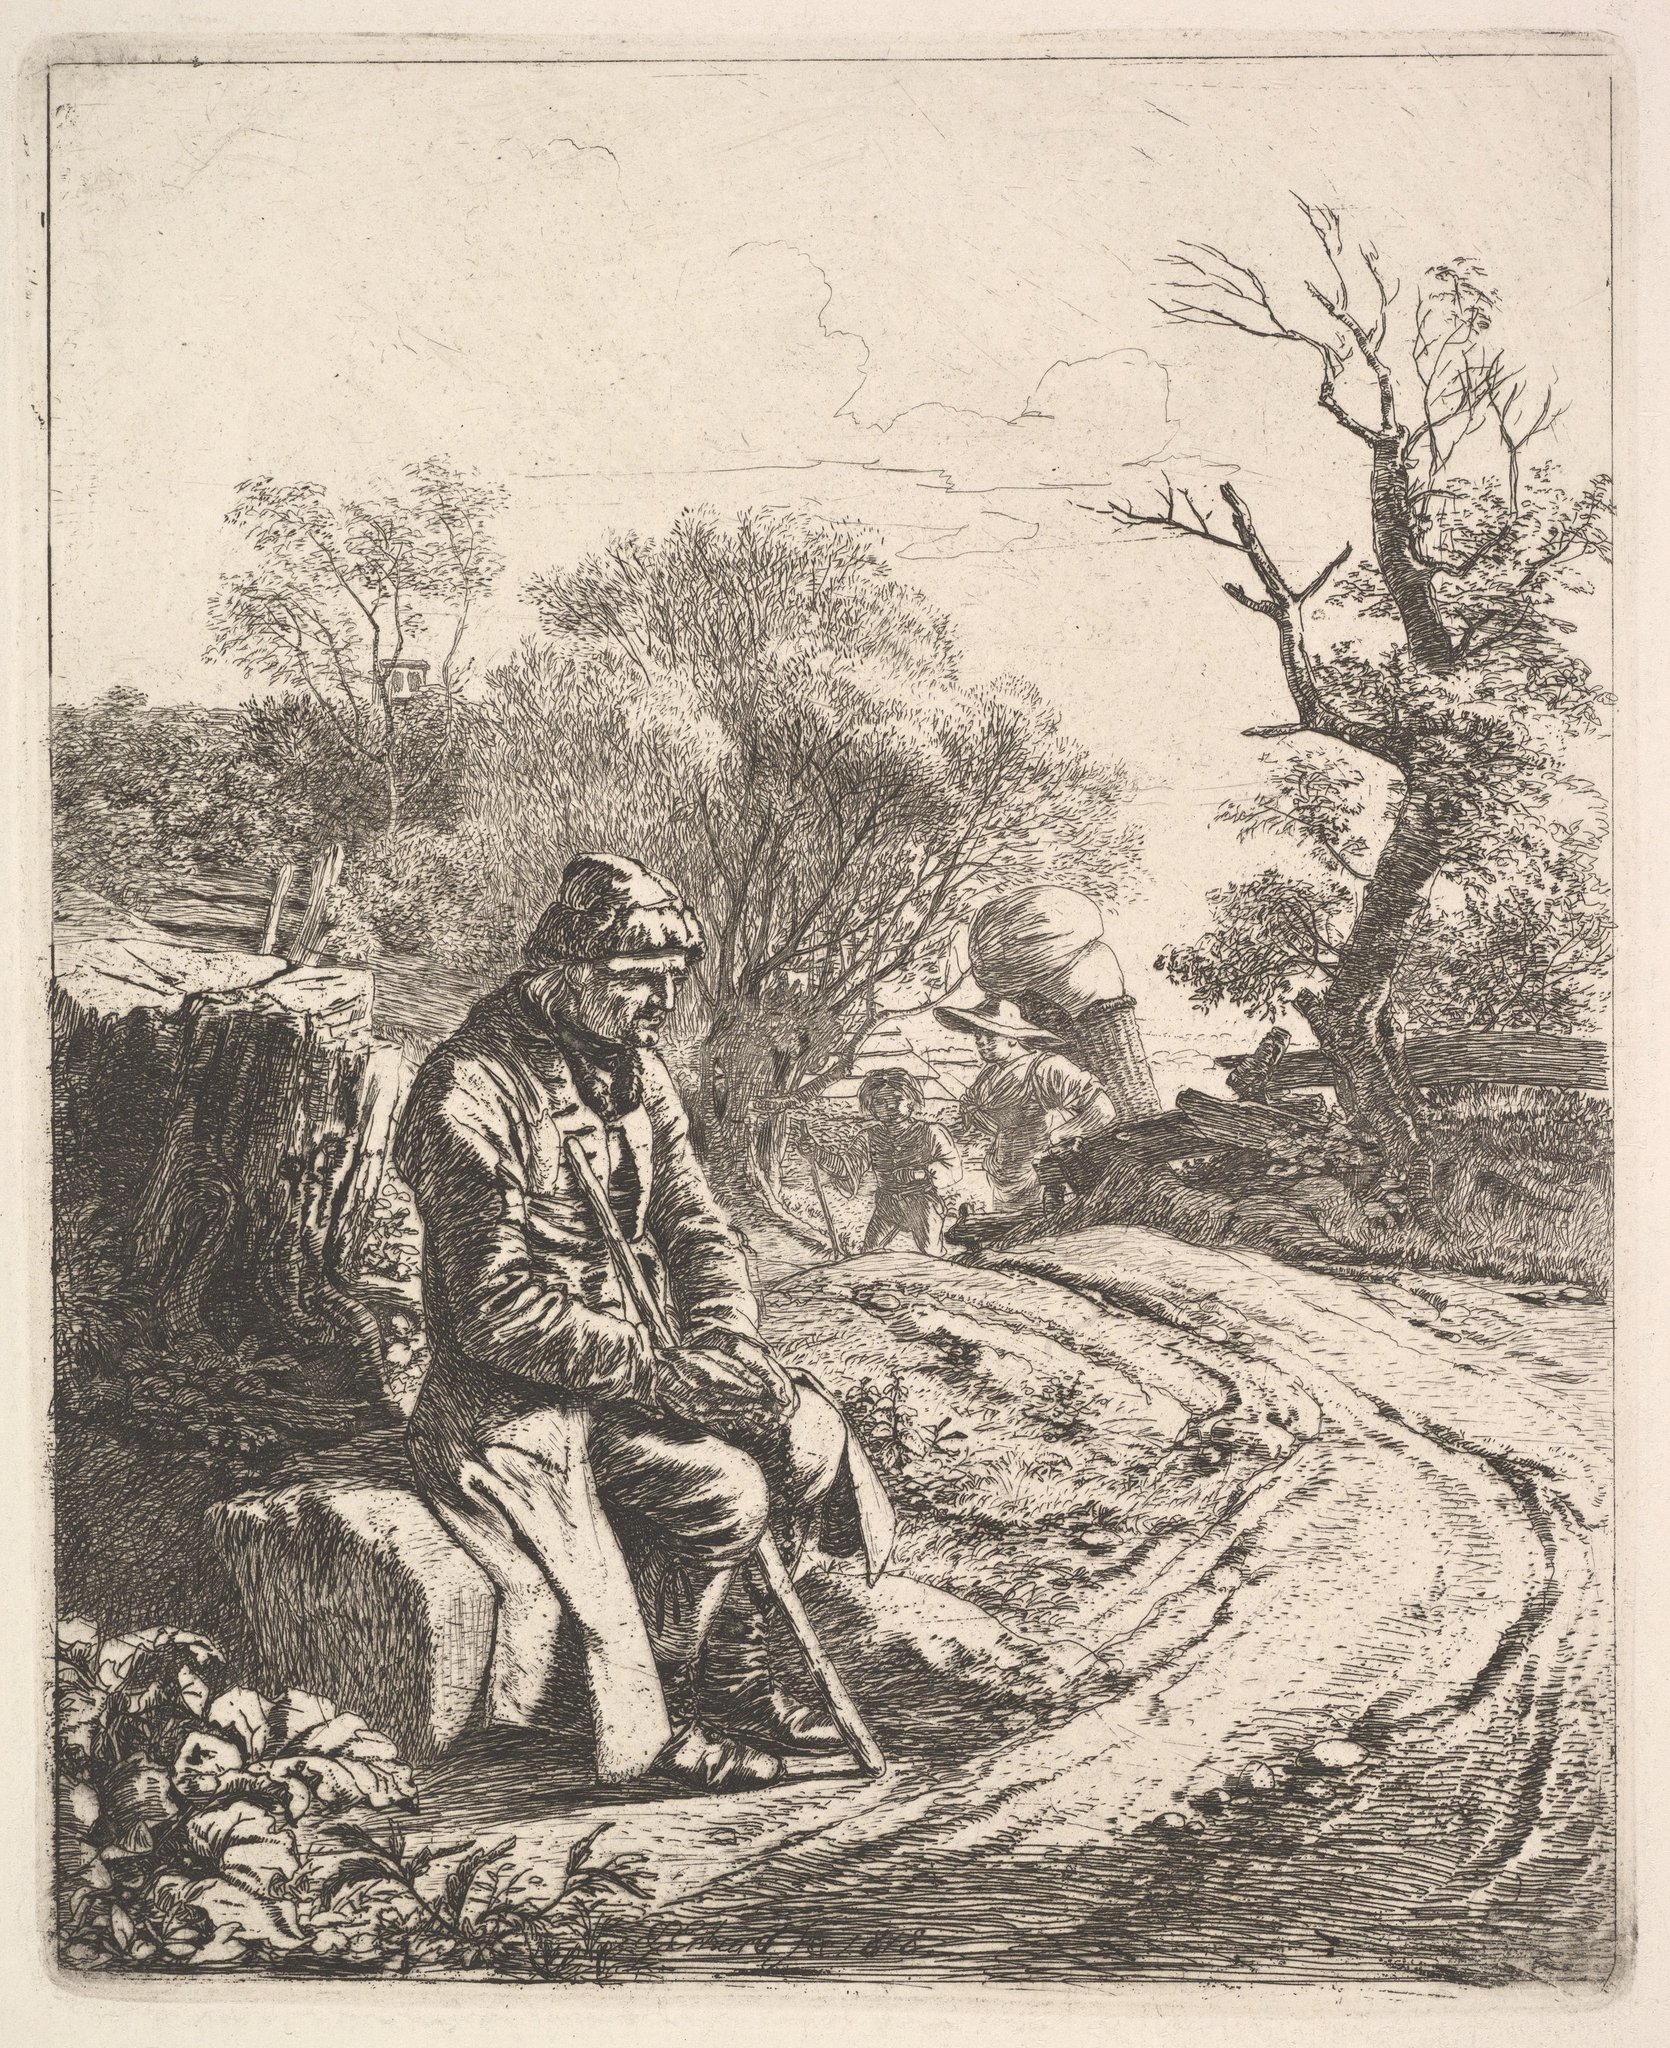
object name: print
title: An Old Man Sitting on the Roadside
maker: johann christoph erhard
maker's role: artist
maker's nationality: german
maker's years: 1795-1822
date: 1818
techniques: etching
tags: roads,men,trees